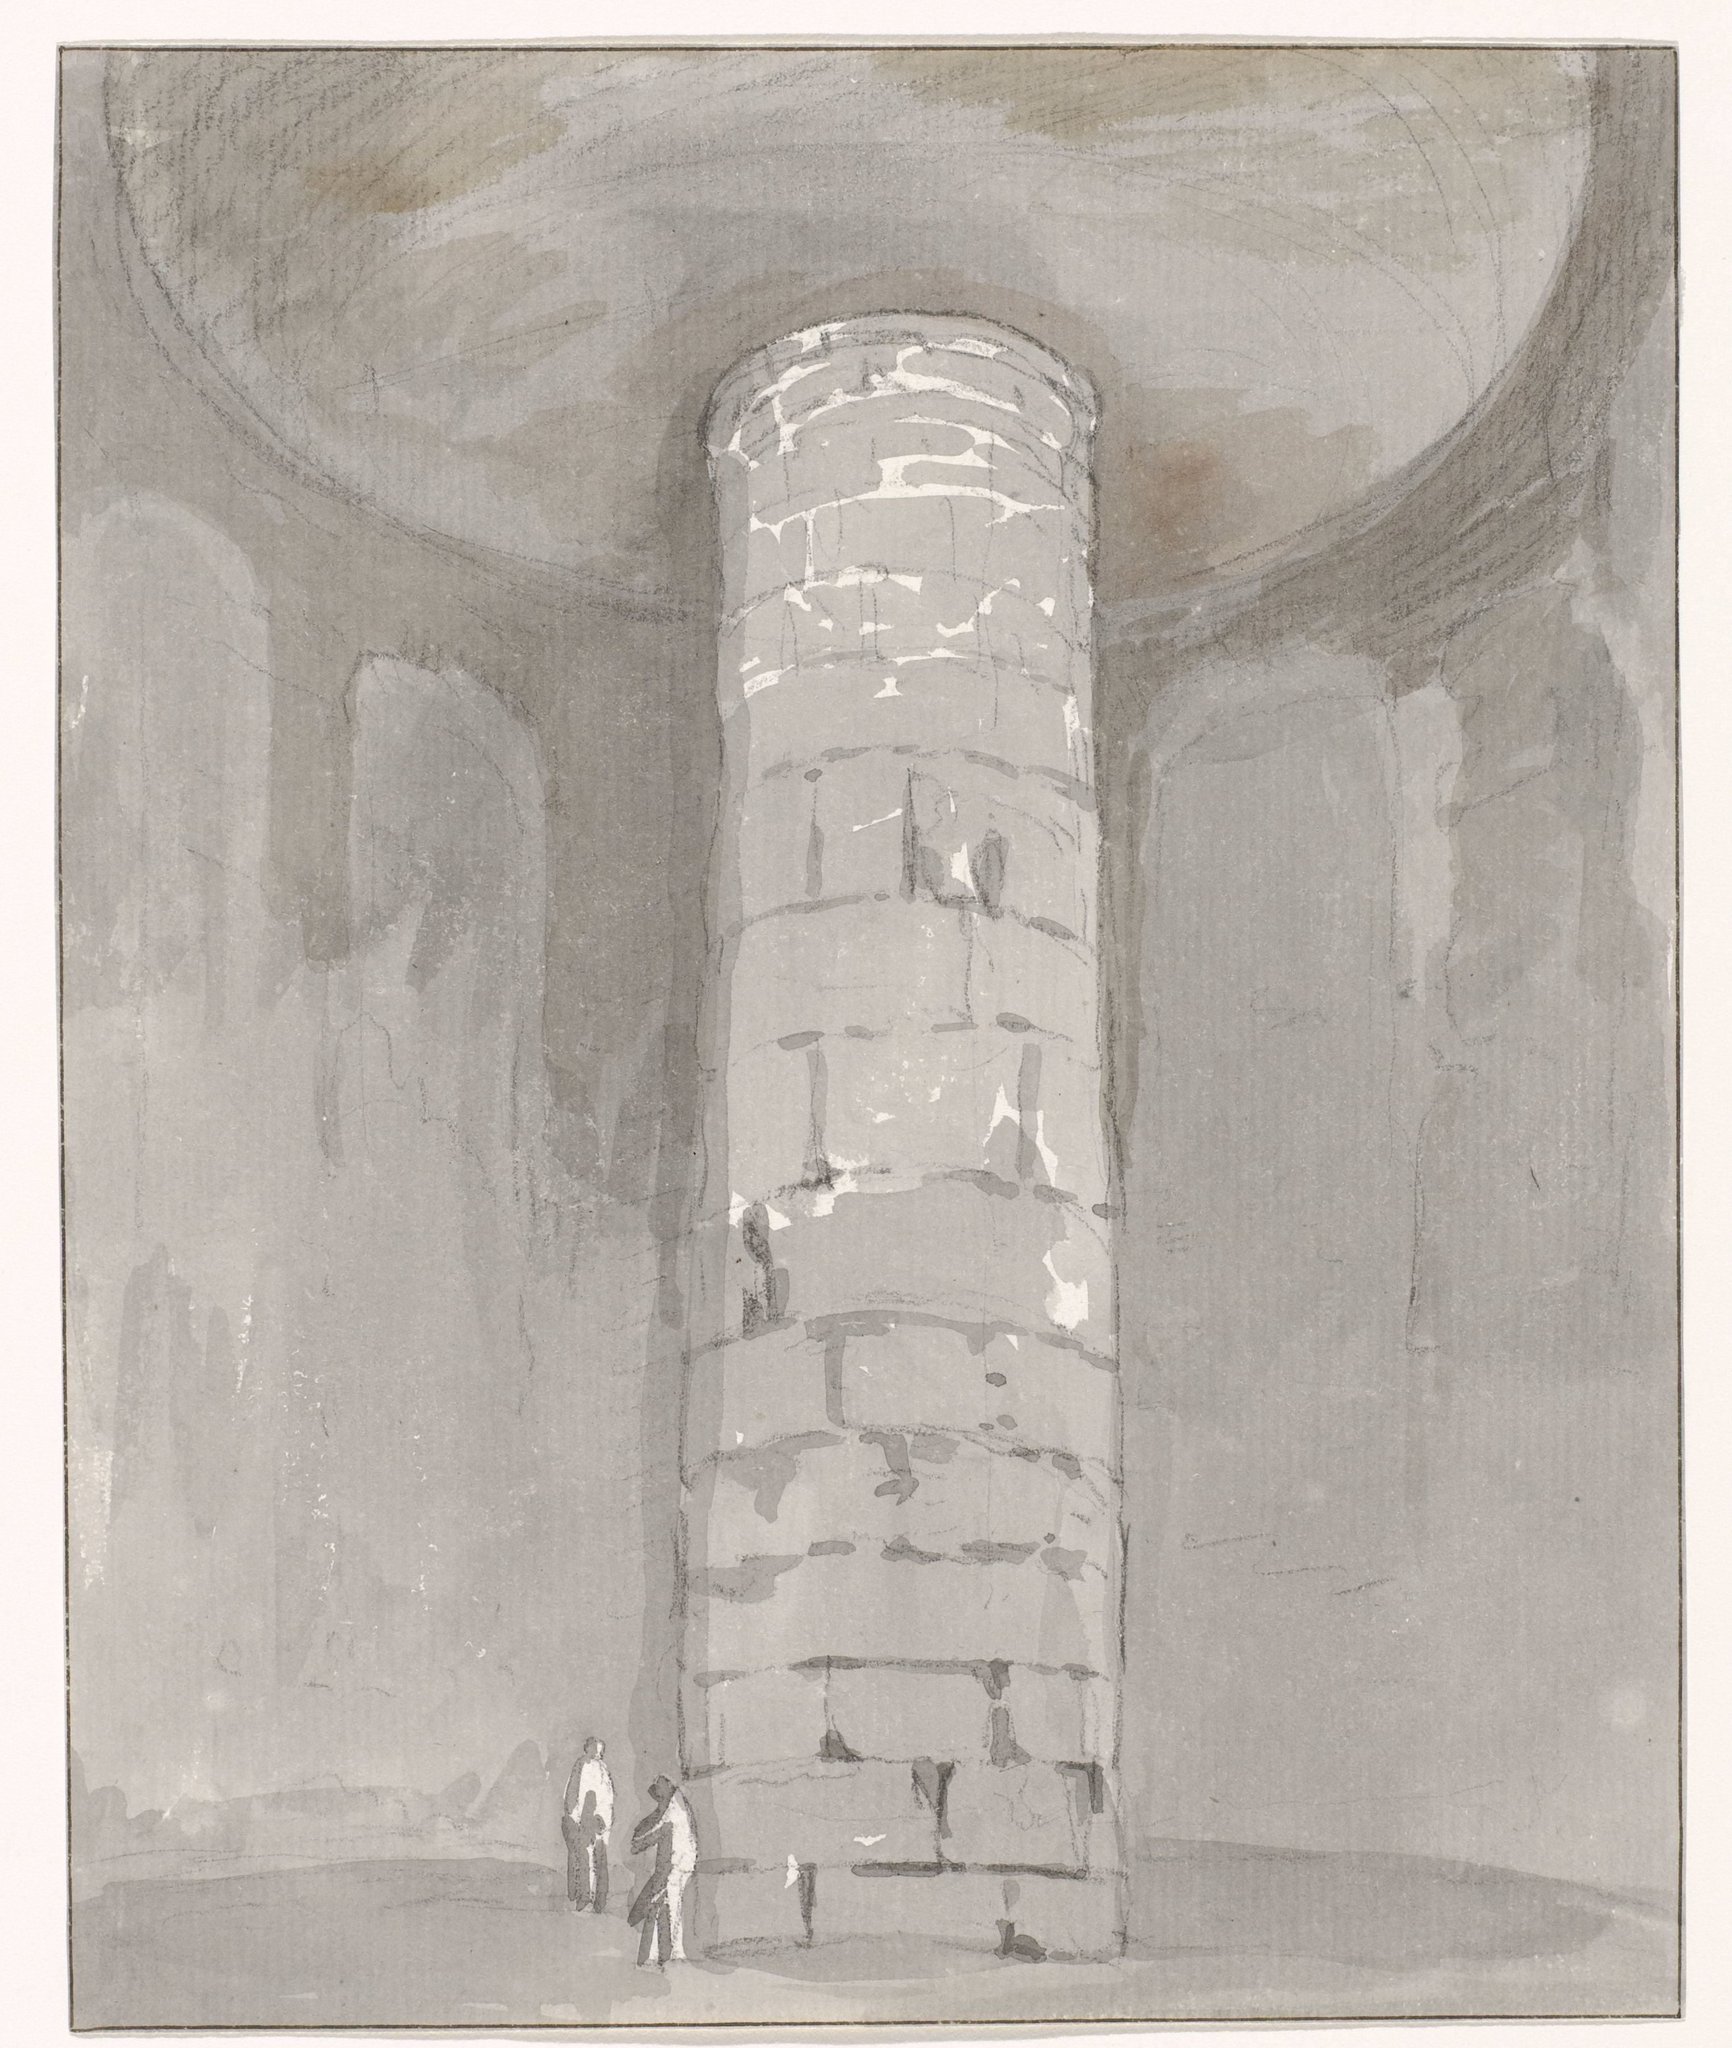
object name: watercolor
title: Interieur van toren op het graf van Ciceron tussen Itri en Gaeta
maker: louis ducros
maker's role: draughtsman, print maker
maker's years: 1748-1810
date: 1778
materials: chalk, paper, watercolor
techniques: brush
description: Tekening uit het album 'Voyage en Italie, en Sicile et à Malte', 1778.